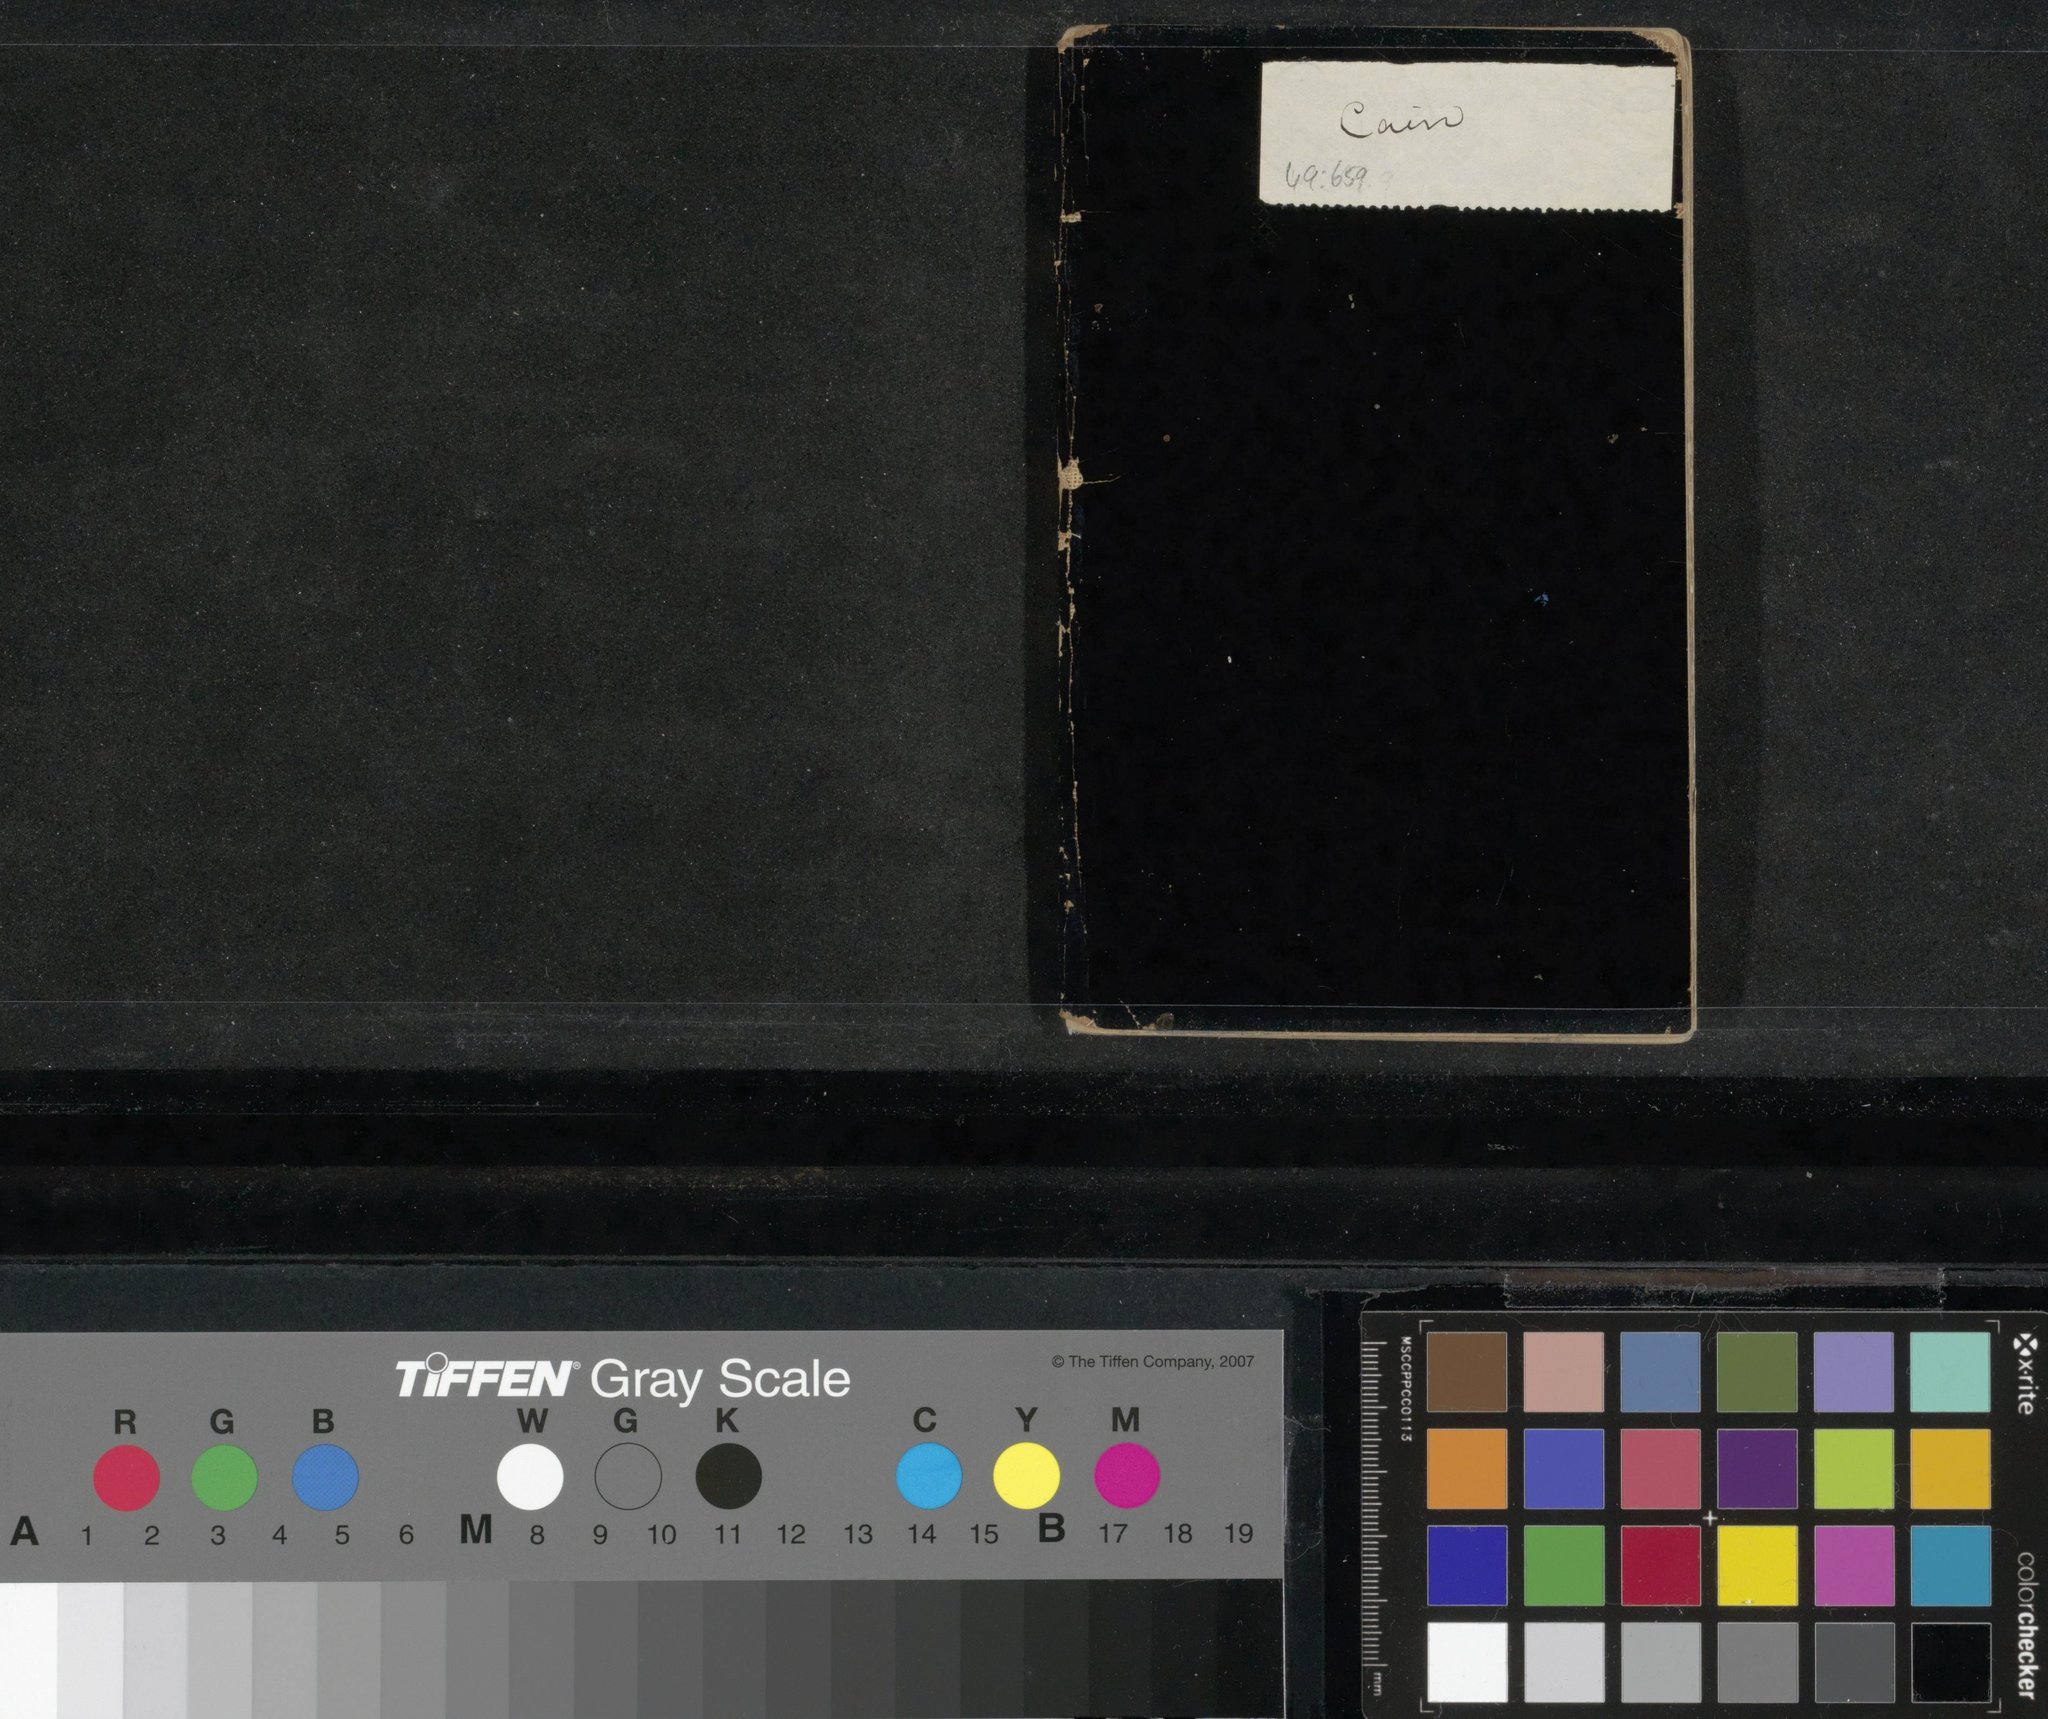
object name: sketchbook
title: Schetsboek met 48 bladen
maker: marius bauer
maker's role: draughtsman, print maker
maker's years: 1867-1932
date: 1894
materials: cardboard, chalk, linen, paper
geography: cairo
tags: desert, temple, shrine ~ islam, mohammedanism, grave-building, monumental tomb, street (+ city(-scape) with figures, staffage)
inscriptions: collector's mark: Lugt 2228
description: Schetsboek bestaande uit 48 bladen met schetsen gemaakt tijdens een reis naar Egypte met stadsgezichten en moskeeën in Caïro, woestijnlandschappen, figuurstudies van Egyptenaren en de Graven van de Kaliefen.